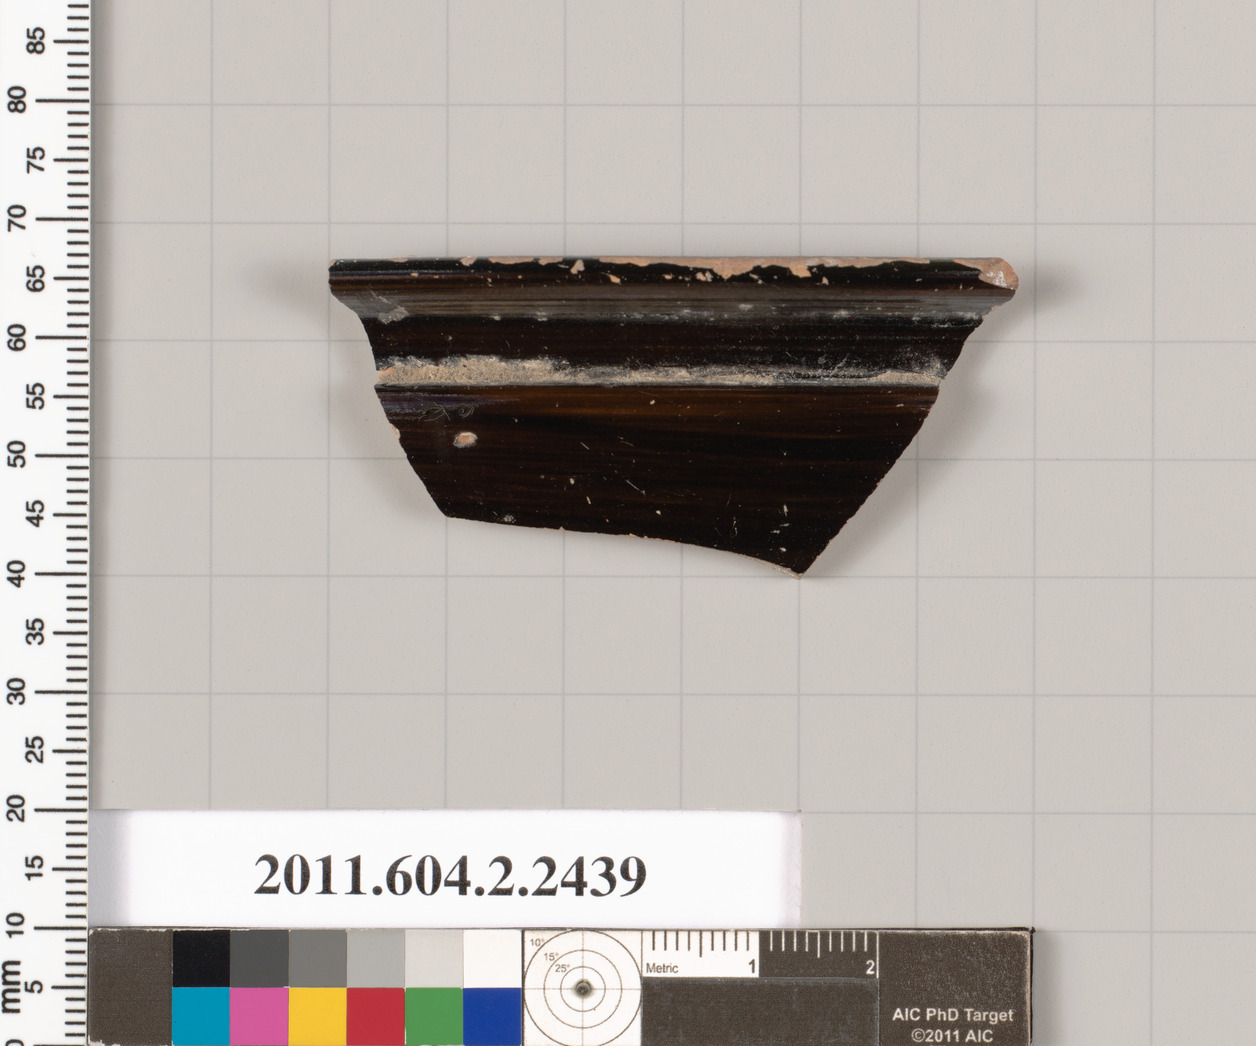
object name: kalathos fragment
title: Terracotta rim fragment from a kalathos?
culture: greek, attic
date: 520-500 BCE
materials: terracotta